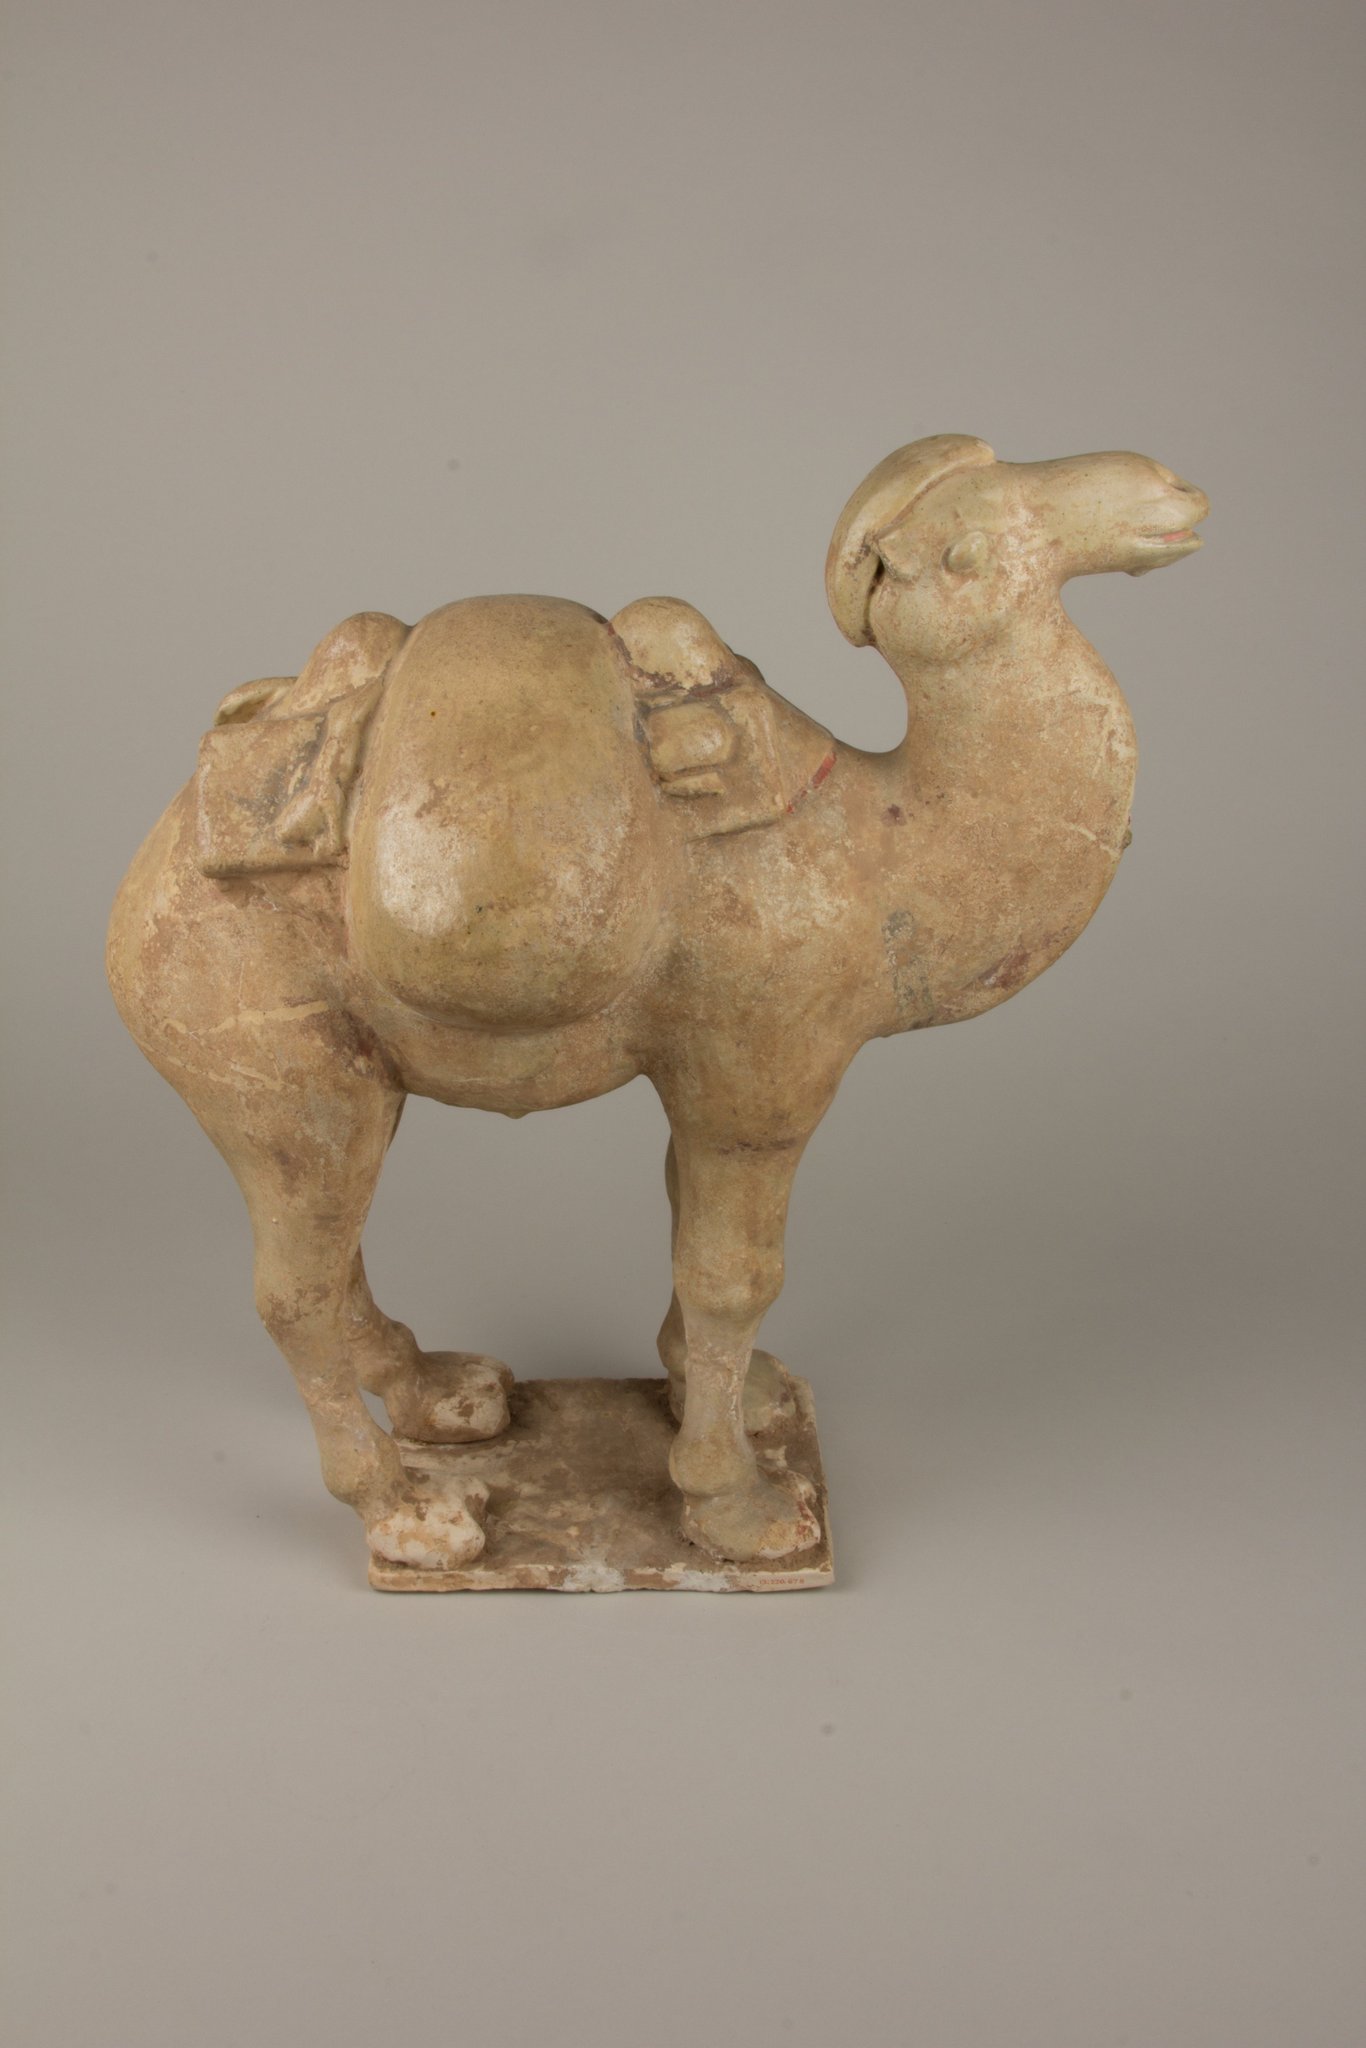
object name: figure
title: Two camels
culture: chinese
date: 601-800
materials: earthenware, pigment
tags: camels